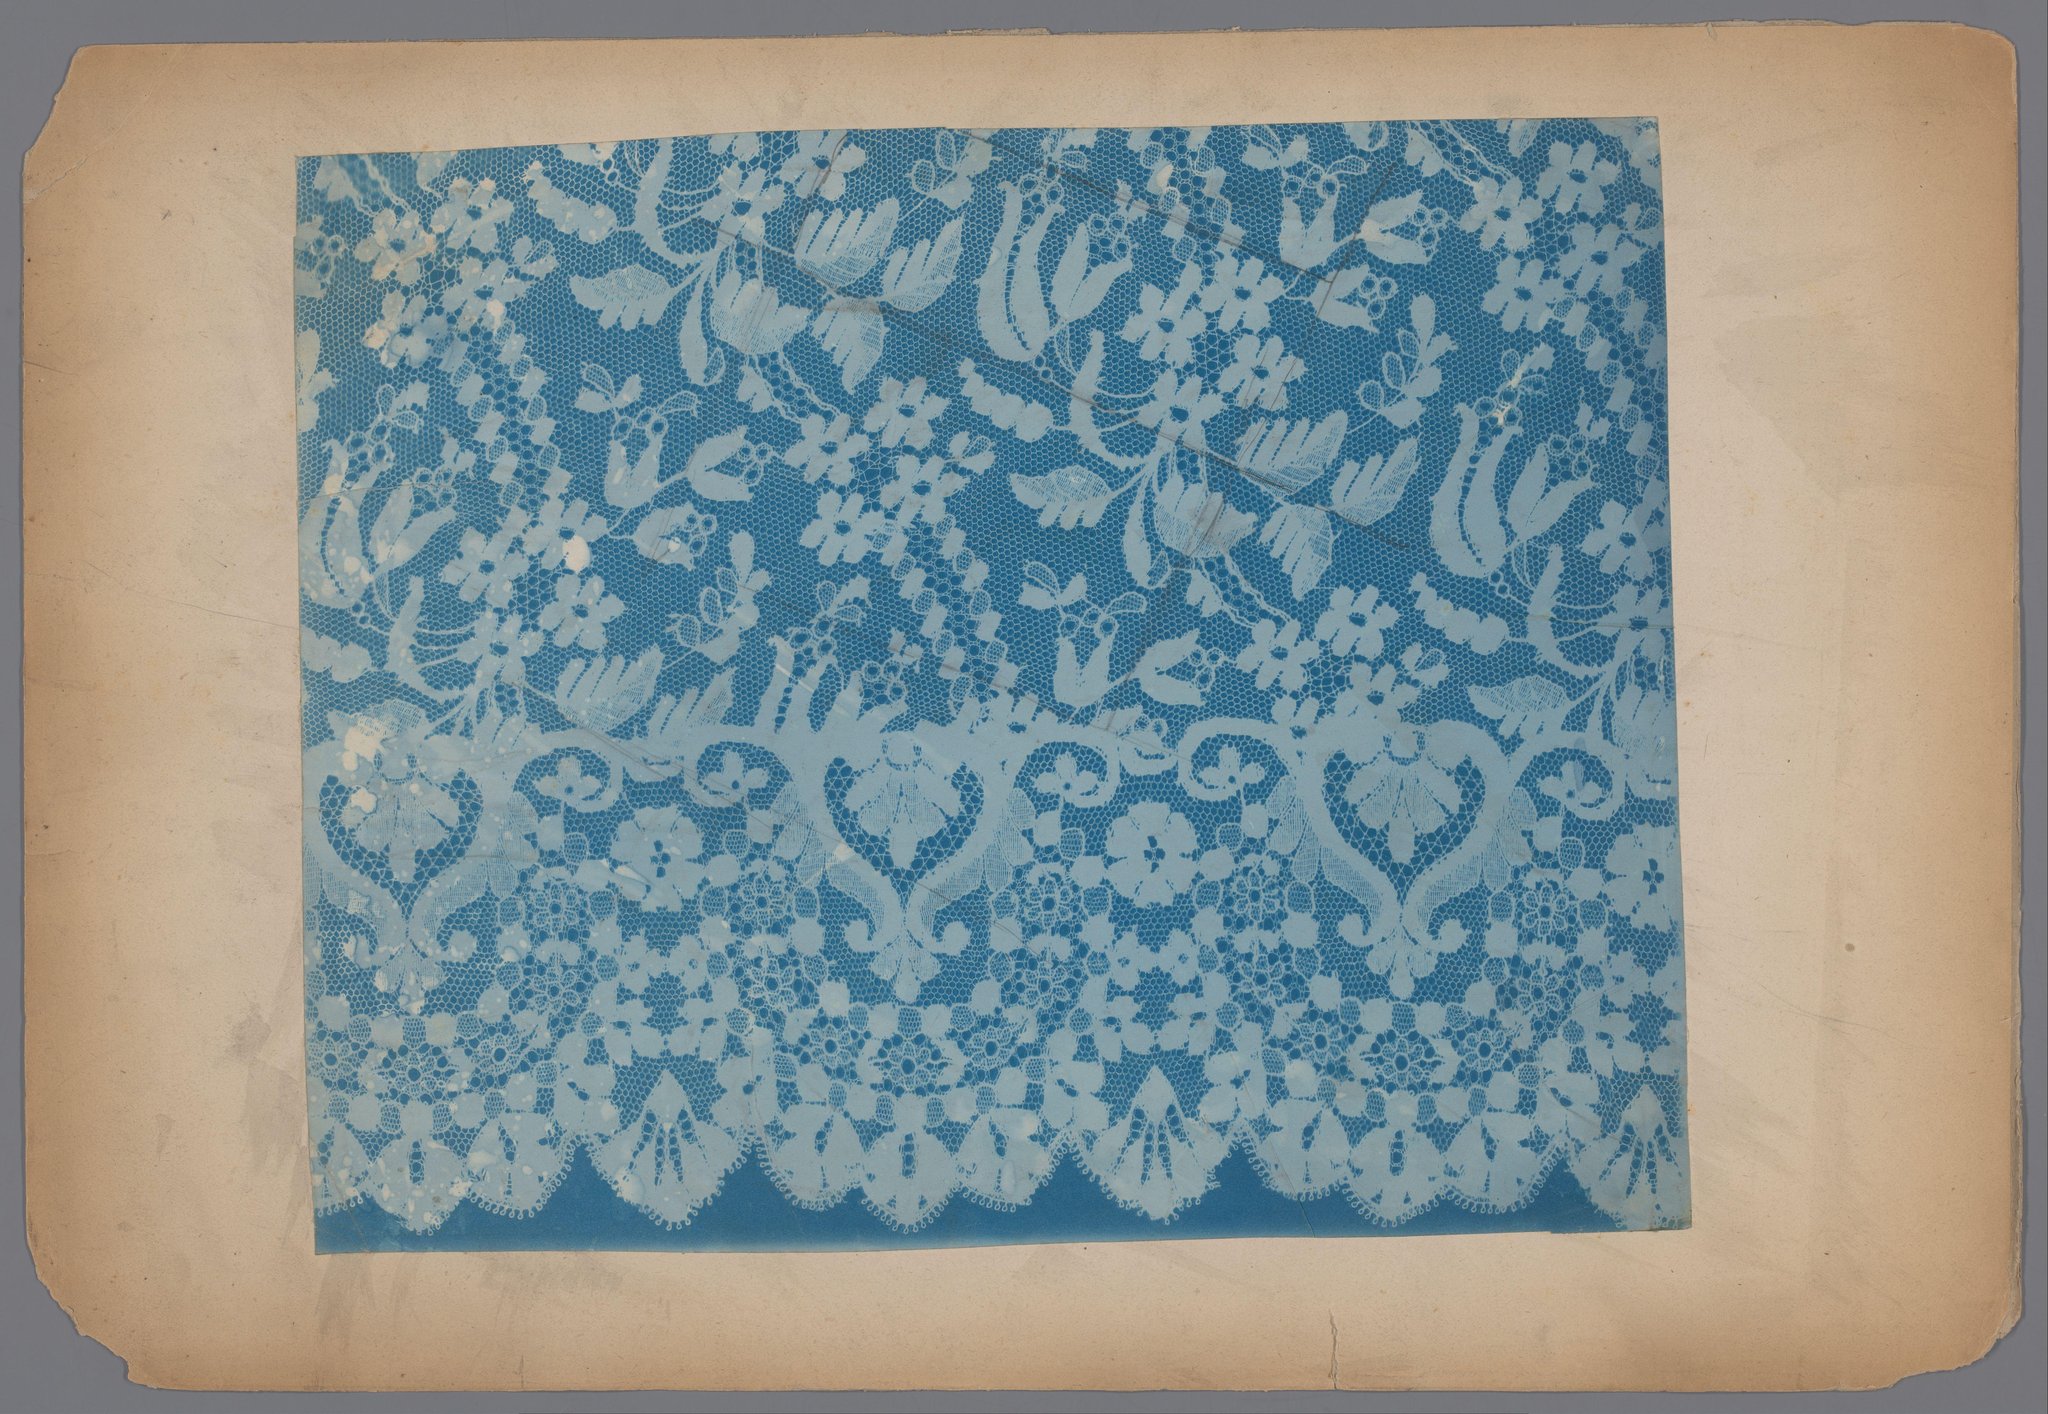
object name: photogram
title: Voorbeeld van kant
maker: Anonymous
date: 1890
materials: paper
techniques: cyanotype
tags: lace